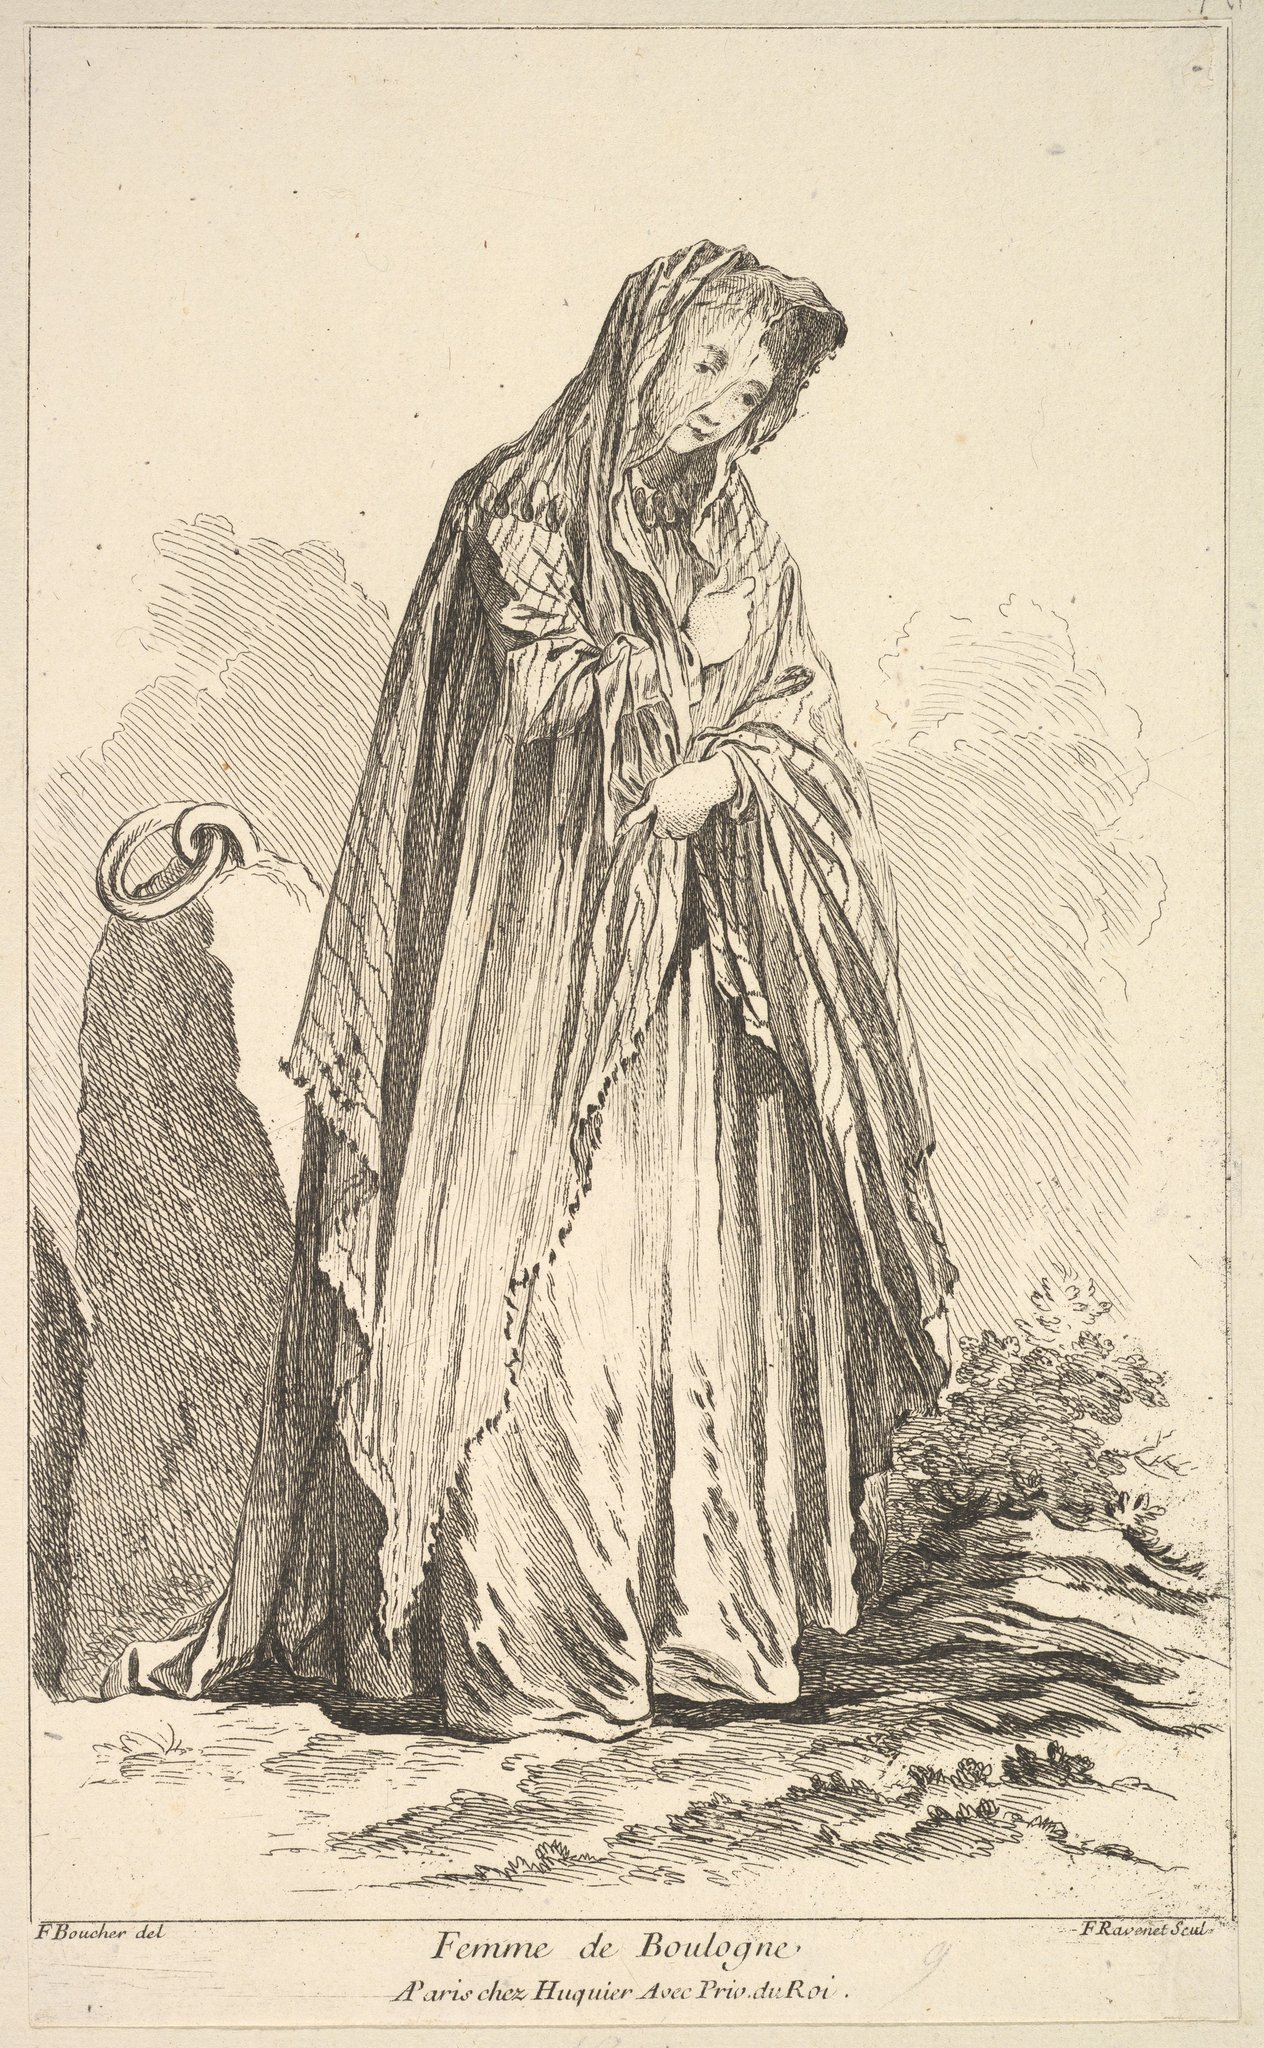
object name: print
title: Femme de Boulogne, plate 9 from "Recueil de diverses fig.res étrangeres Inventées par F. Boucher P.tre du Roy et Gravées par F. Ravenet" (Collection of Various Foreign Figures, Devised by F. Boucher, Painter of the King and Engraved [etched] by F. Ravenet)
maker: simon francis ravenet, the elder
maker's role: artist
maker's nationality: french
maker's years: 1706-1774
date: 1701-1800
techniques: engraving, etching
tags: women